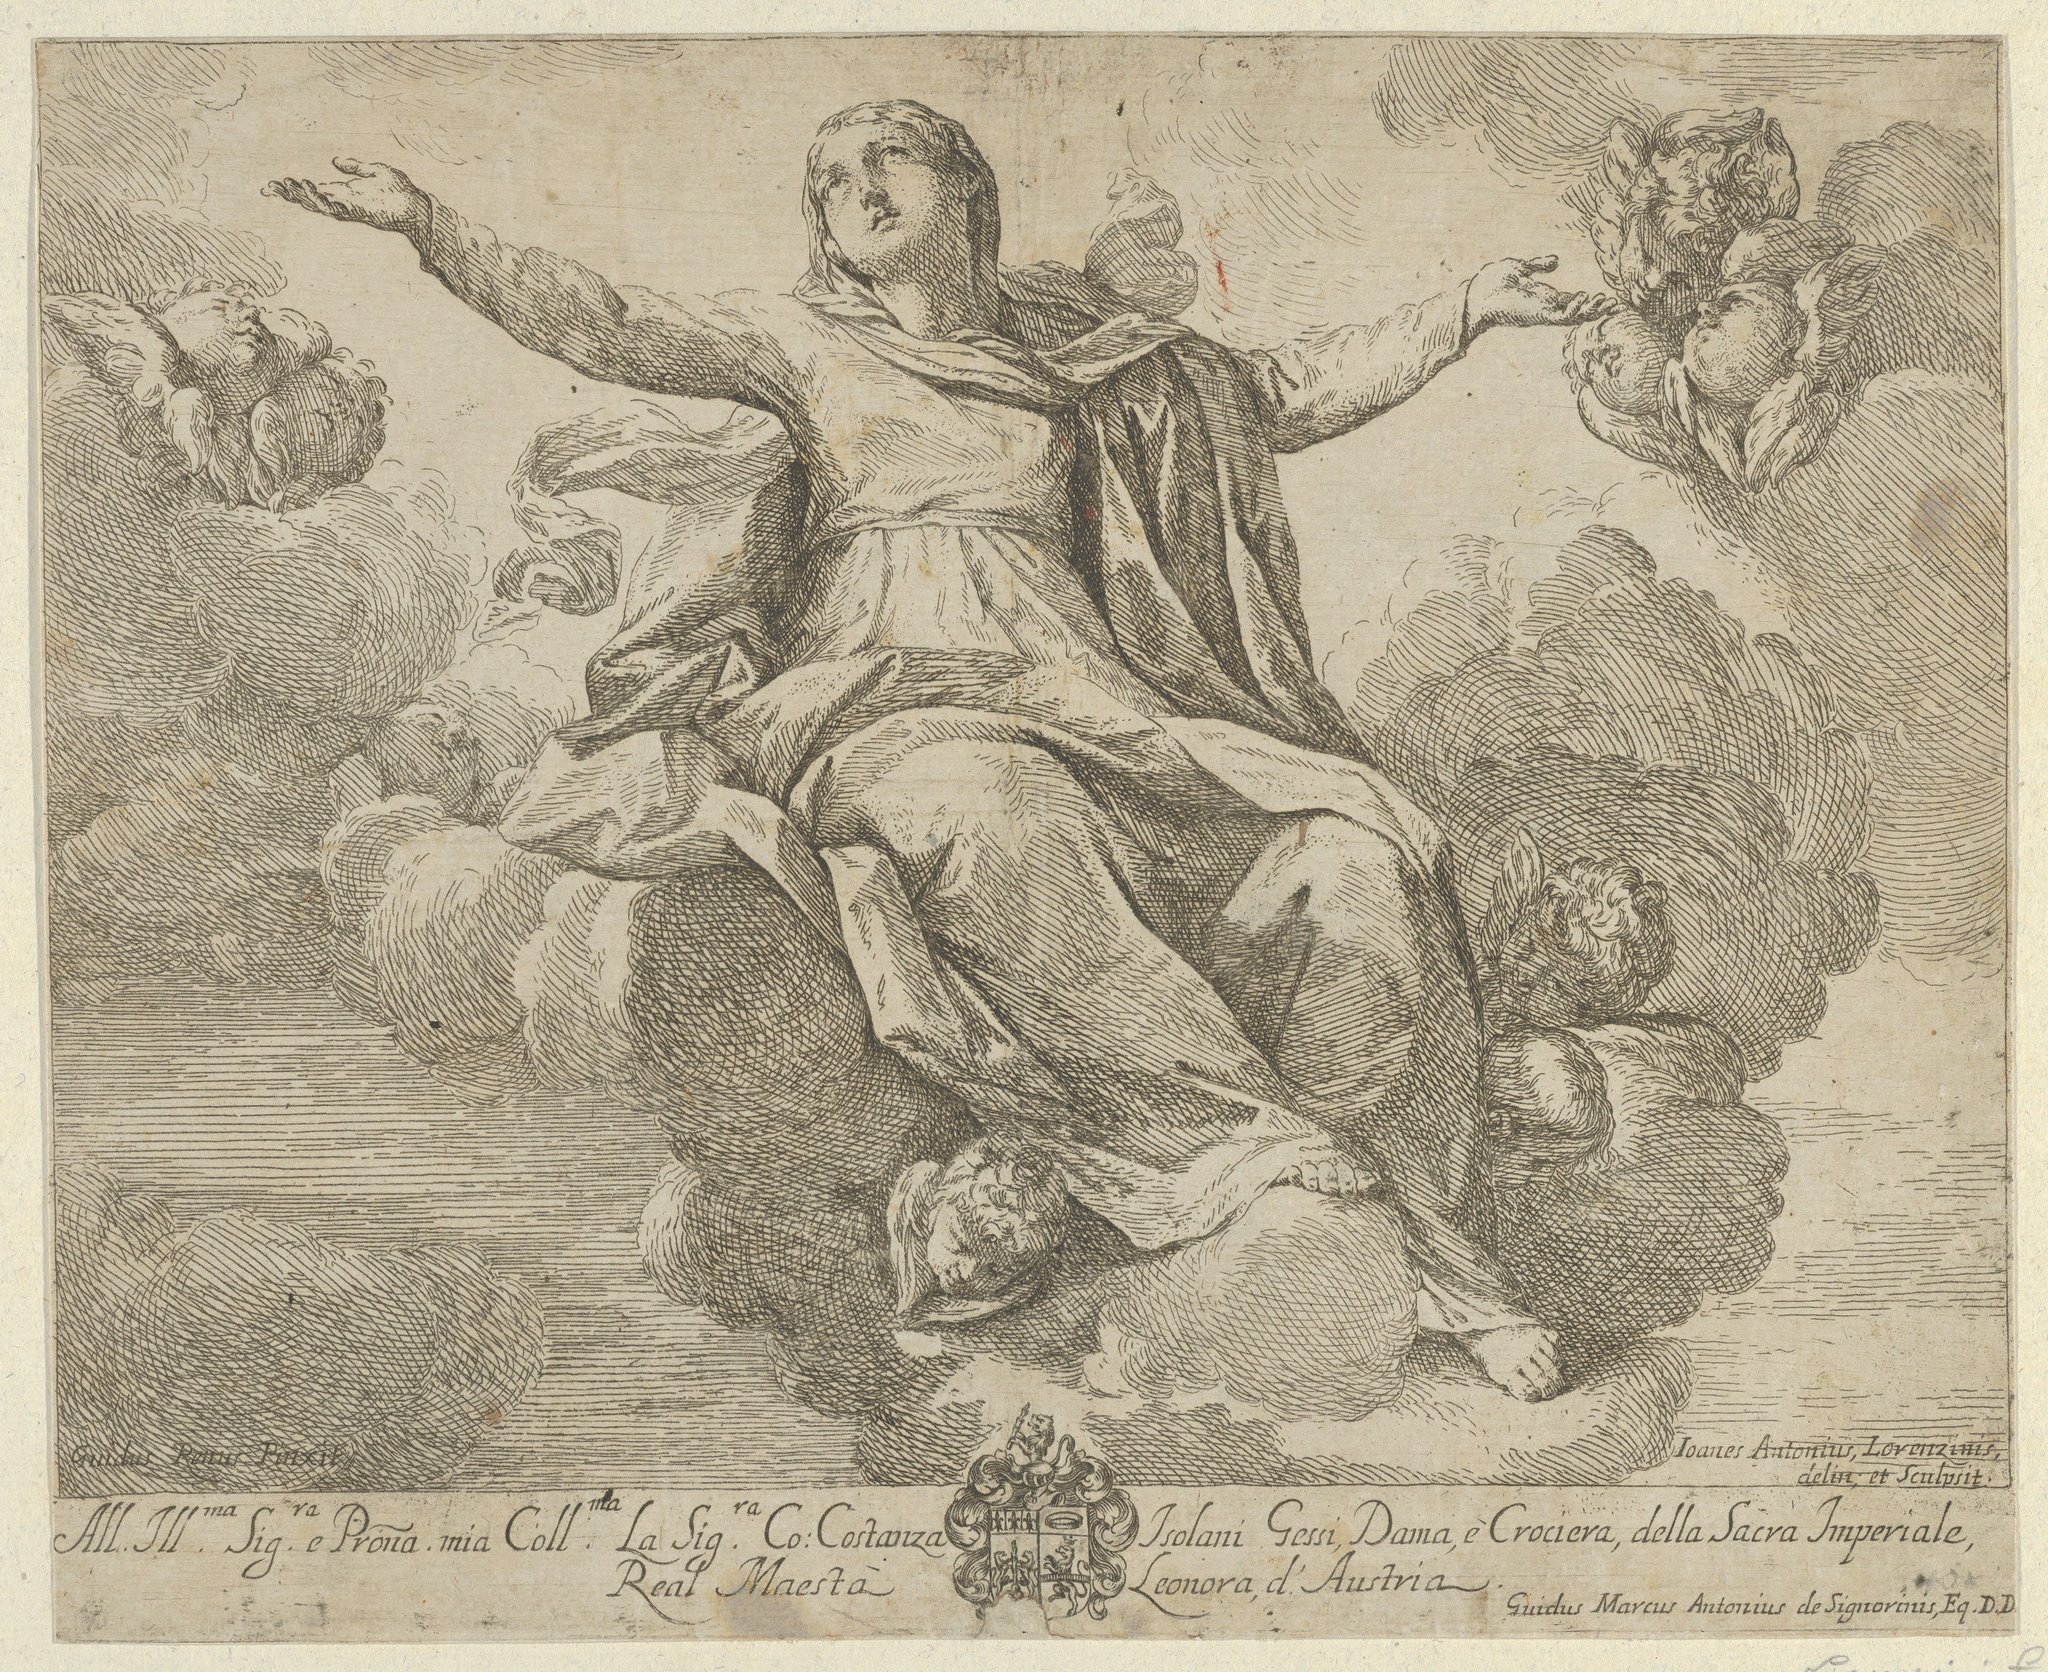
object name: print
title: The Assumption of the Virgin, who is seated in the clouds with arms outstretched, angels surrounding her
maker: fra antonio lorenzini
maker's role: artist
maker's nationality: italian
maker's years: 1665-1740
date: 1685-1720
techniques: etching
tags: angels,virgin mary,assumption of the virgin